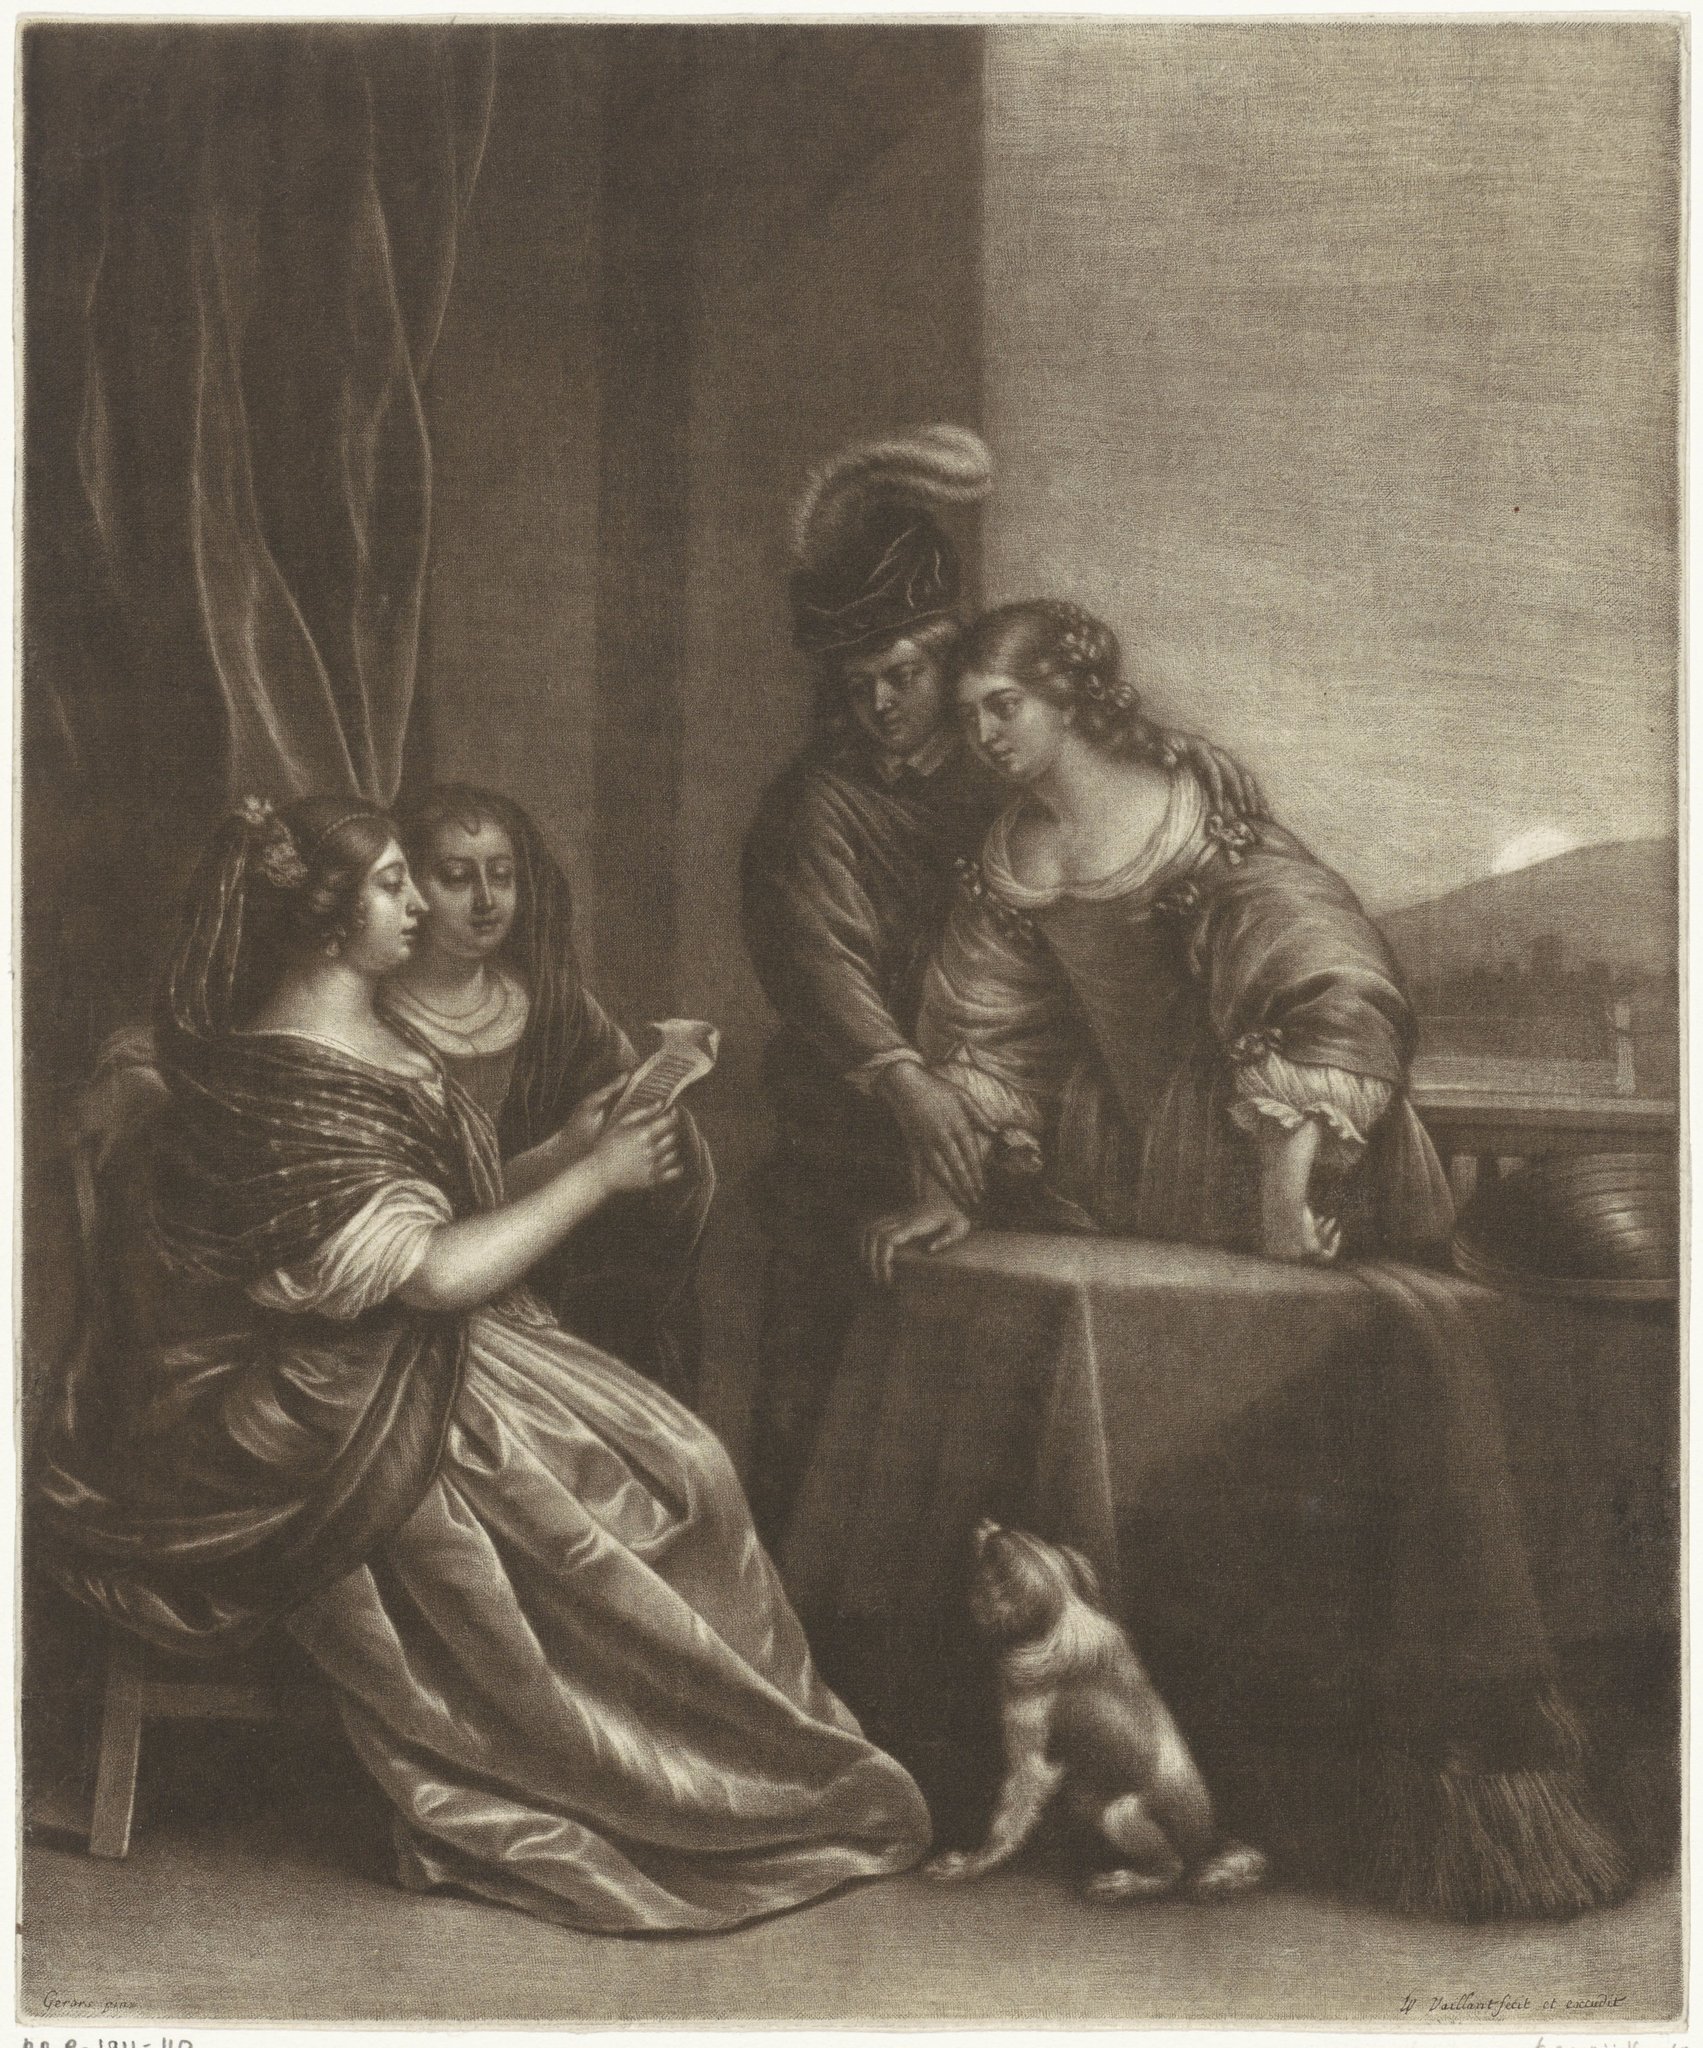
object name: print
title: Brieflezende vrouw op een terras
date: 1658-1677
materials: paper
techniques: mezzotint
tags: reading, landscapes, letter, envelope, dog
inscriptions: collector's mark: Lugt 2228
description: Op een terras leest een vrouw een brief voor aan twee andere vrouwen en een man. Voor haar zit een hondje. Op de achtergrond een glooiend landschap.